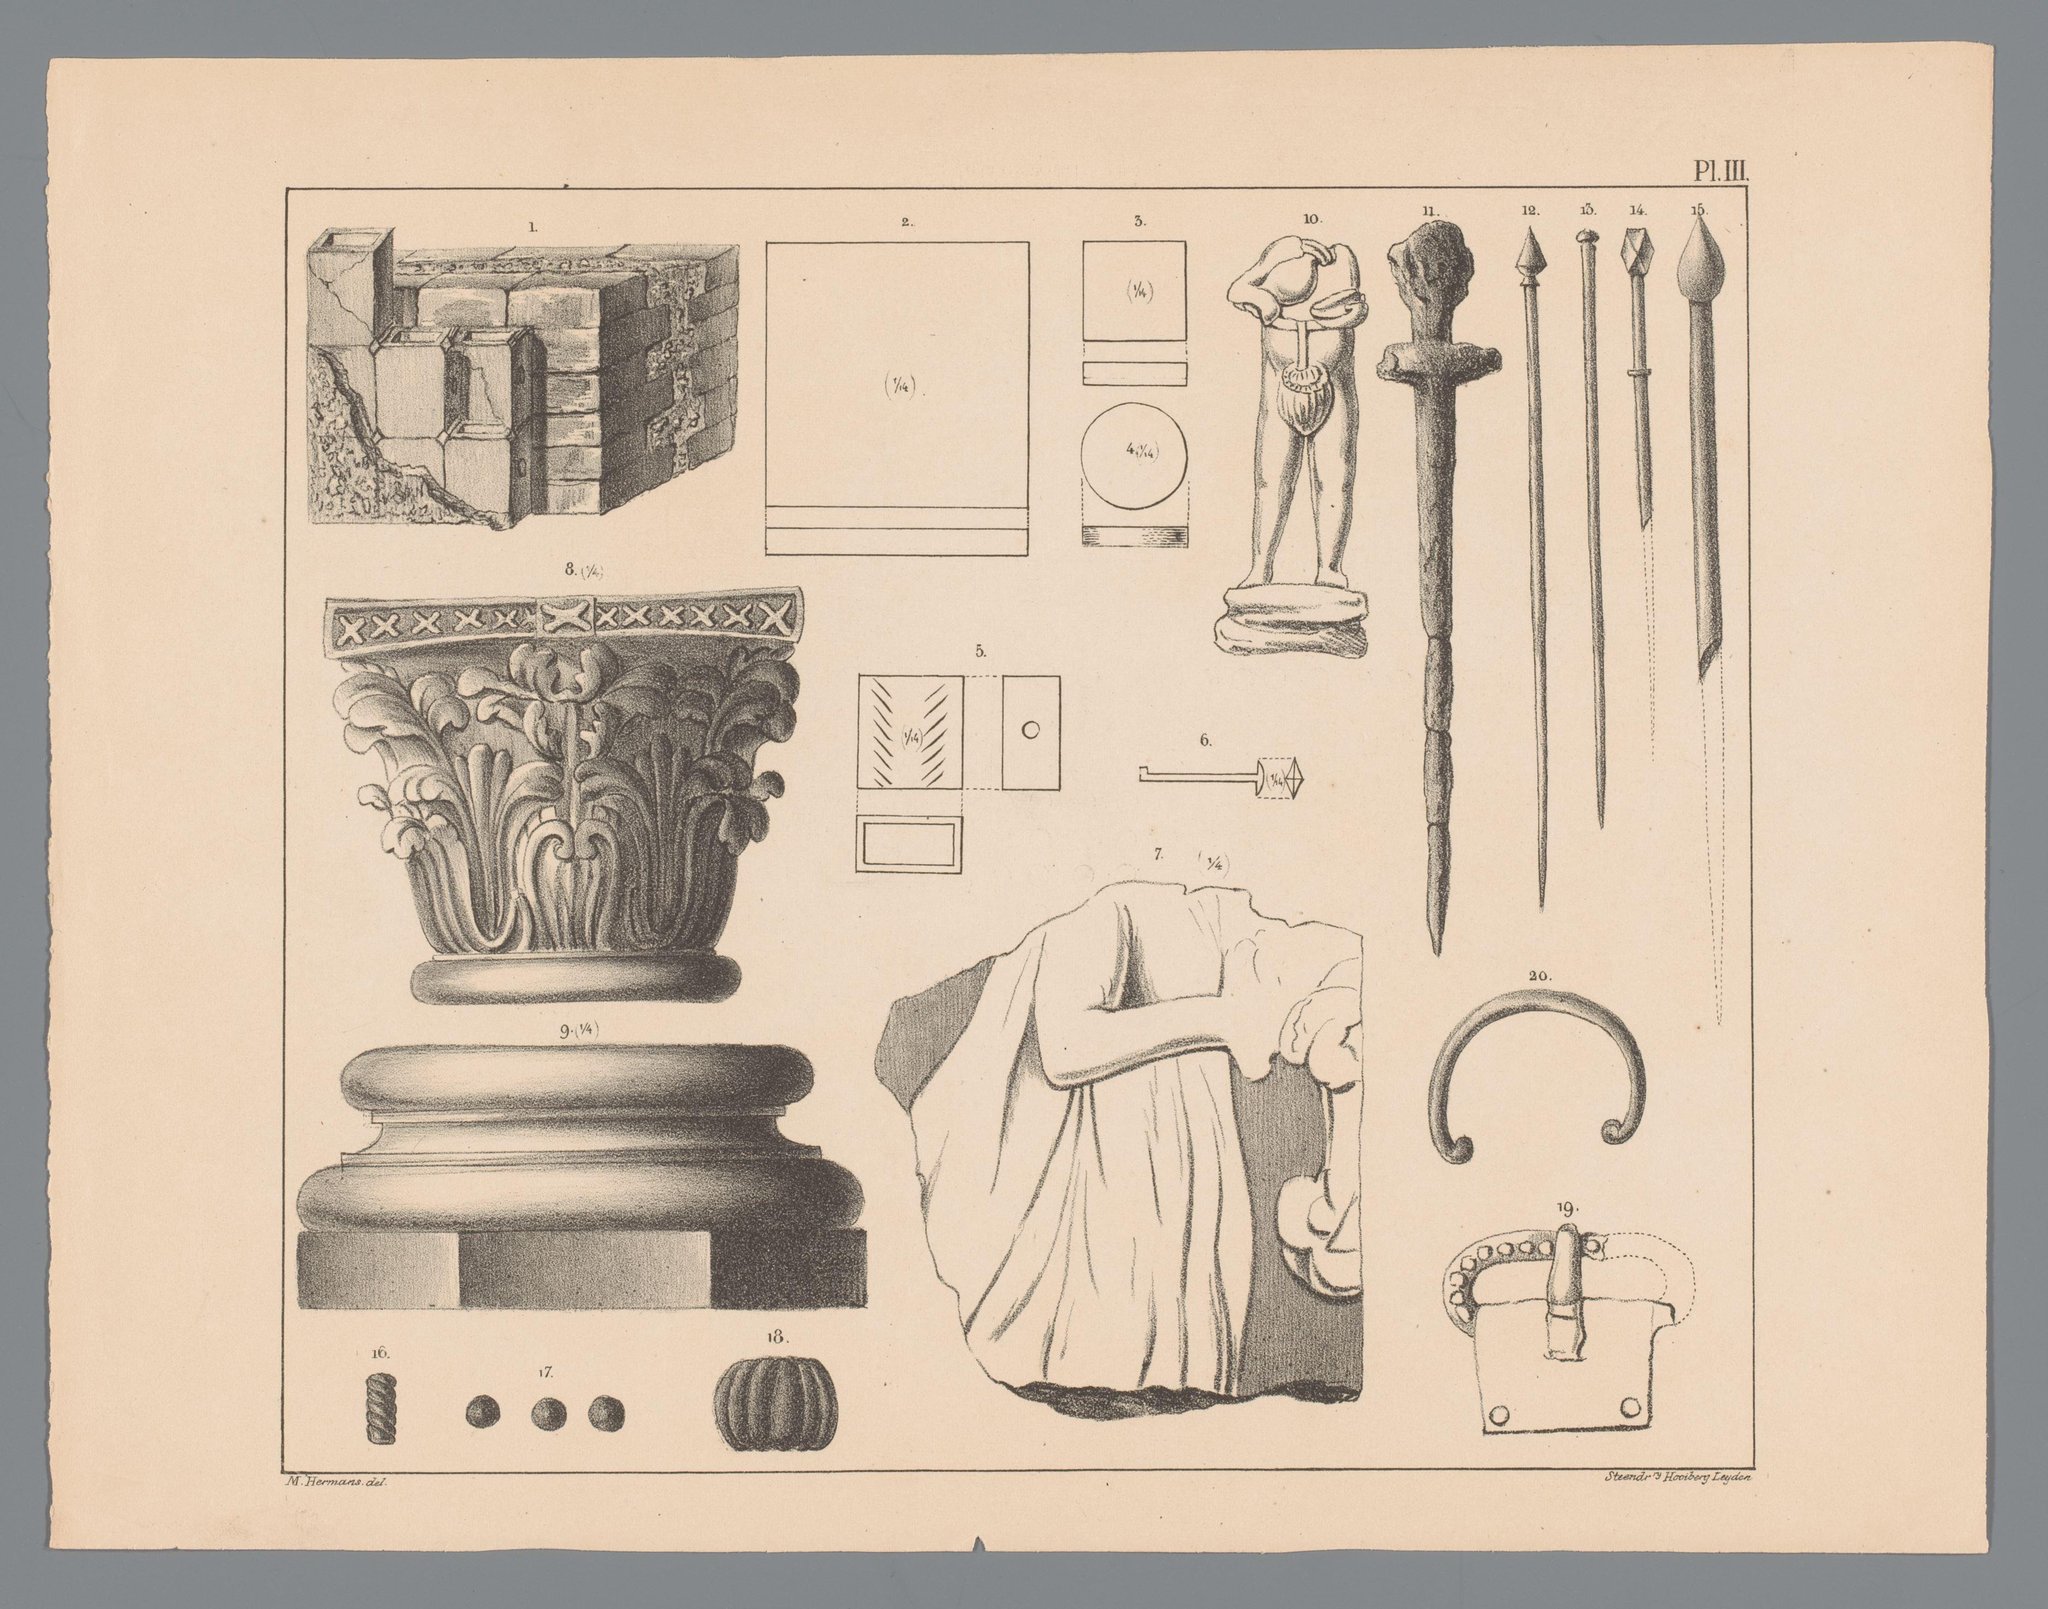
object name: print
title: Romeinse opgravingen waaronder een korintisch kapiteel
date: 1843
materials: paper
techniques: lithograph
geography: leiden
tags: excavation ~ archaeology (+ collection, exhibition ~ results of research), brooch, agraffe, clasp, rome (one of the four world empires), corinthian order ~ architecture, maastricht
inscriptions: collector's mark: Lugt 2228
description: De objecten zijn genummerd. Afgebeeld zijn onder andere speren, een deel van een reliëf met een figuur en een gesp. Genummerd rechtsboven: Pl. III.